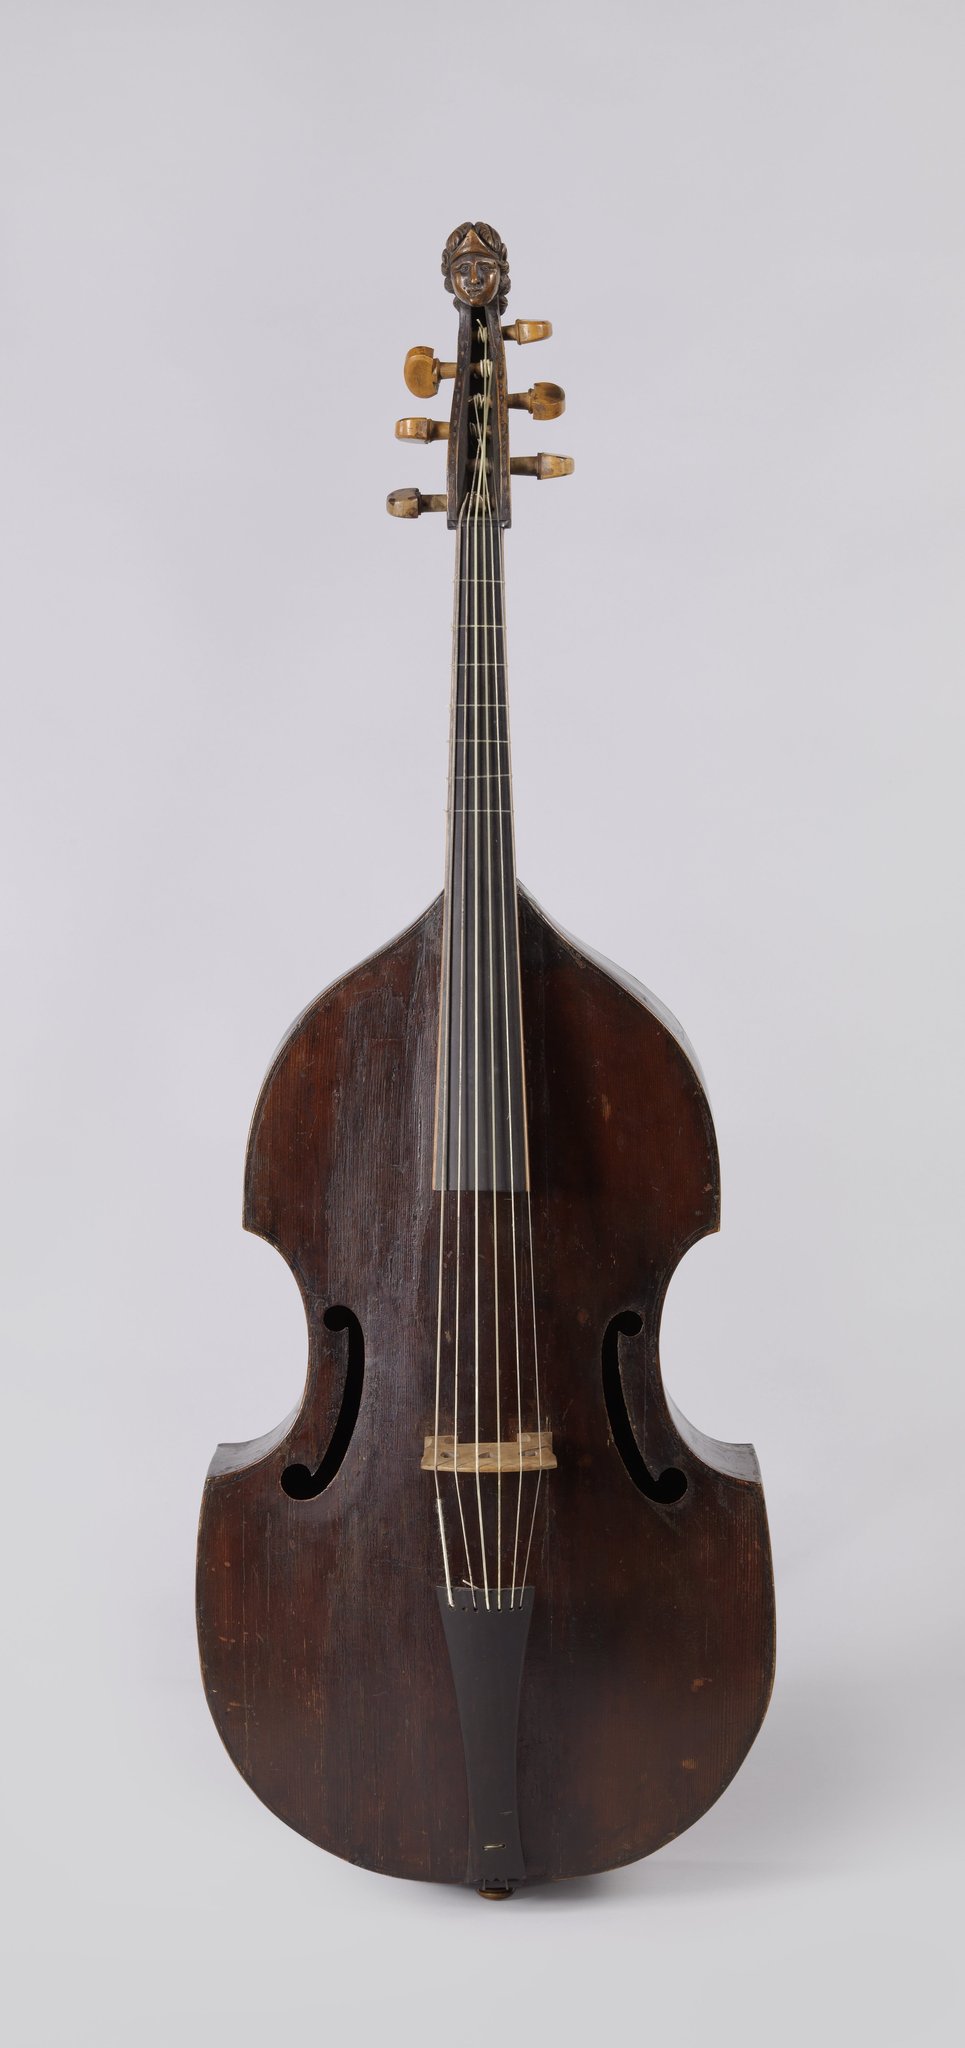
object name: stringed instrument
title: Bass viol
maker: Anonymous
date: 1700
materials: wood, intestine, metal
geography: amsterdam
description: This bass viol has a dubious label bearing with the name 'John Roos'. This falsification was probably intended to suggest the renowned 16th-century English viol maker John Rose. They are more likely late 17th-century viols by the famous Pieter Rombouts of Amsterdam or someone of his school. Unusually, the seven-stringed instrument still has its original carrying case.